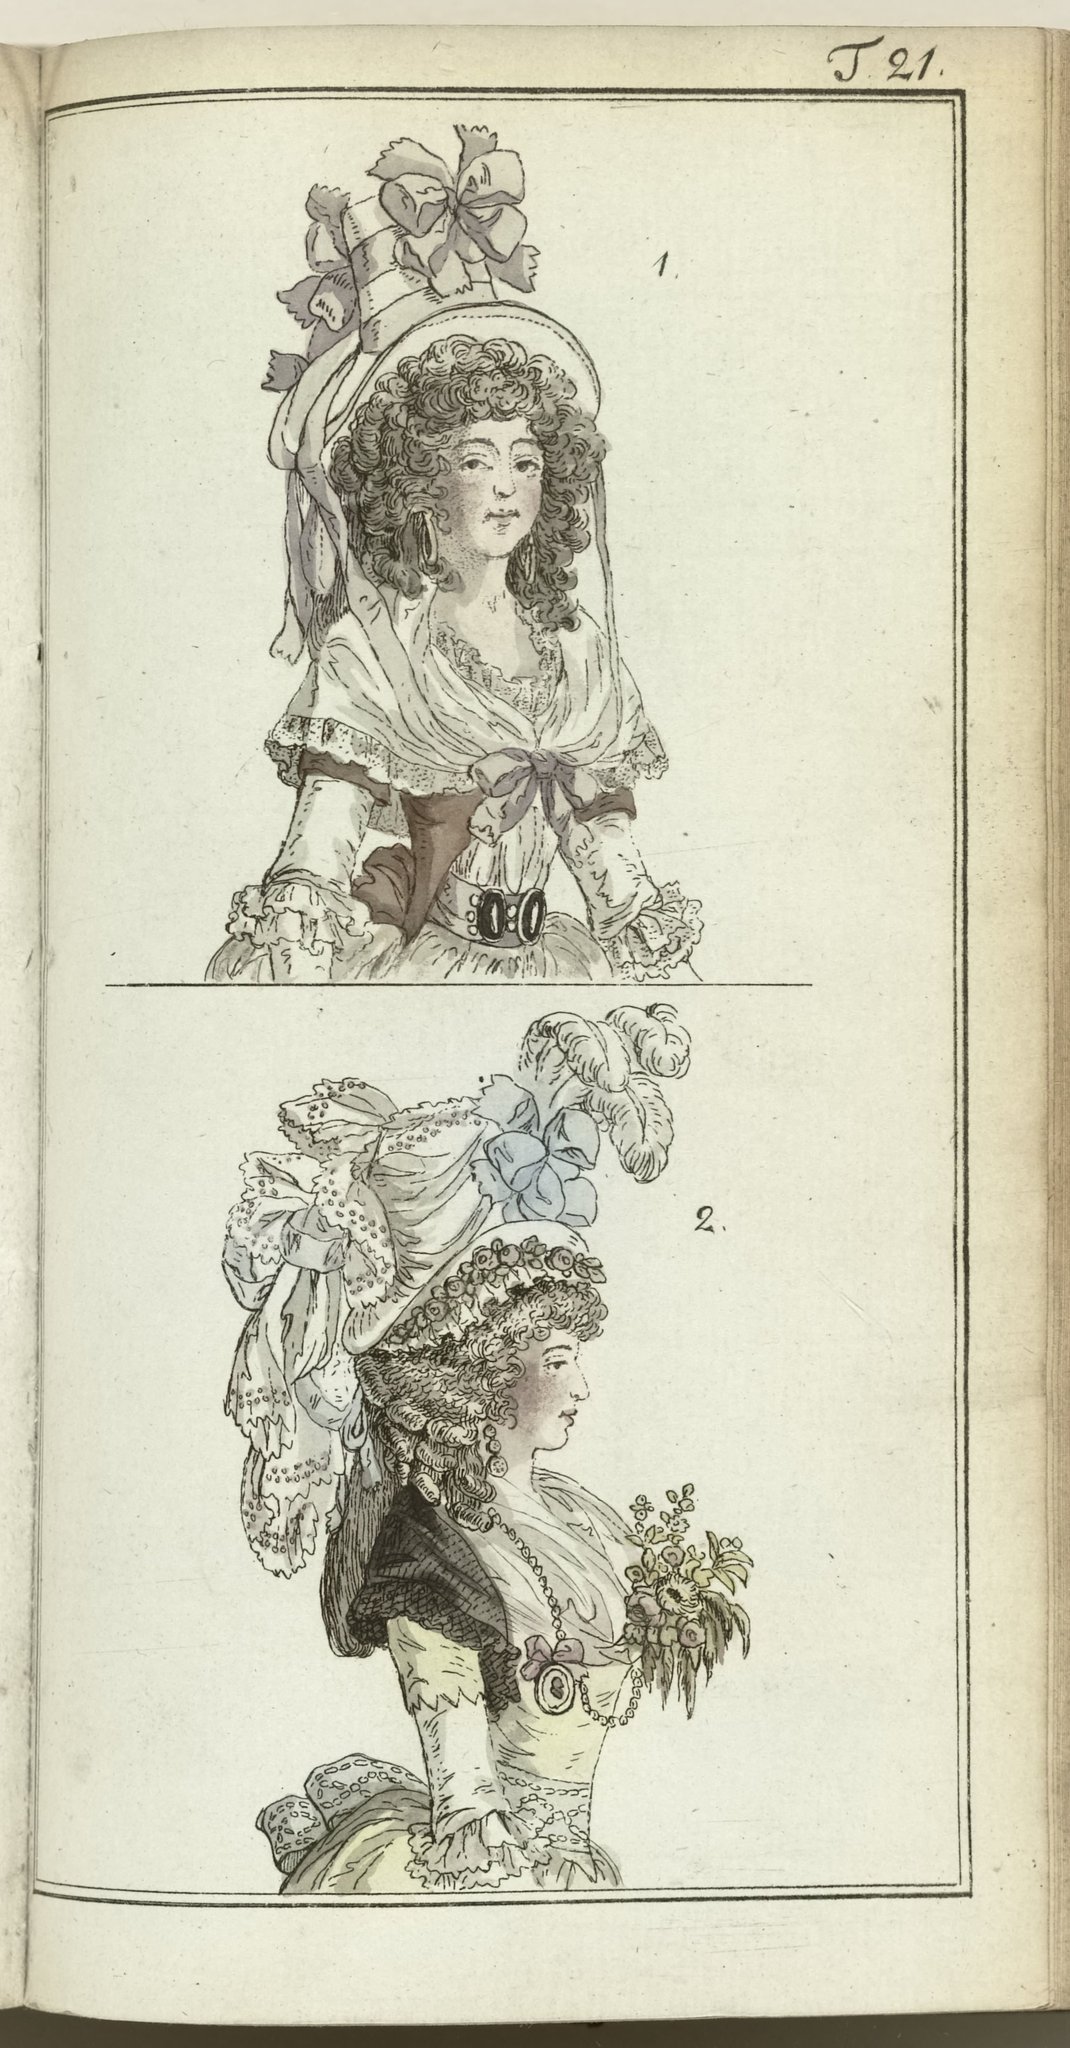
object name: magazine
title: Journal des Luxus und der Moden 1790, Band V, T.21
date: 1790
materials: paper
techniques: etching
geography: weimar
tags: fashion plates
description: Prent uit het modetijdschrift Journal des Luxus und der Moden, uitgegeven door Friedrich Justin Bertuch en Georg Melchior Kraus, Weimar, 1786-1826.